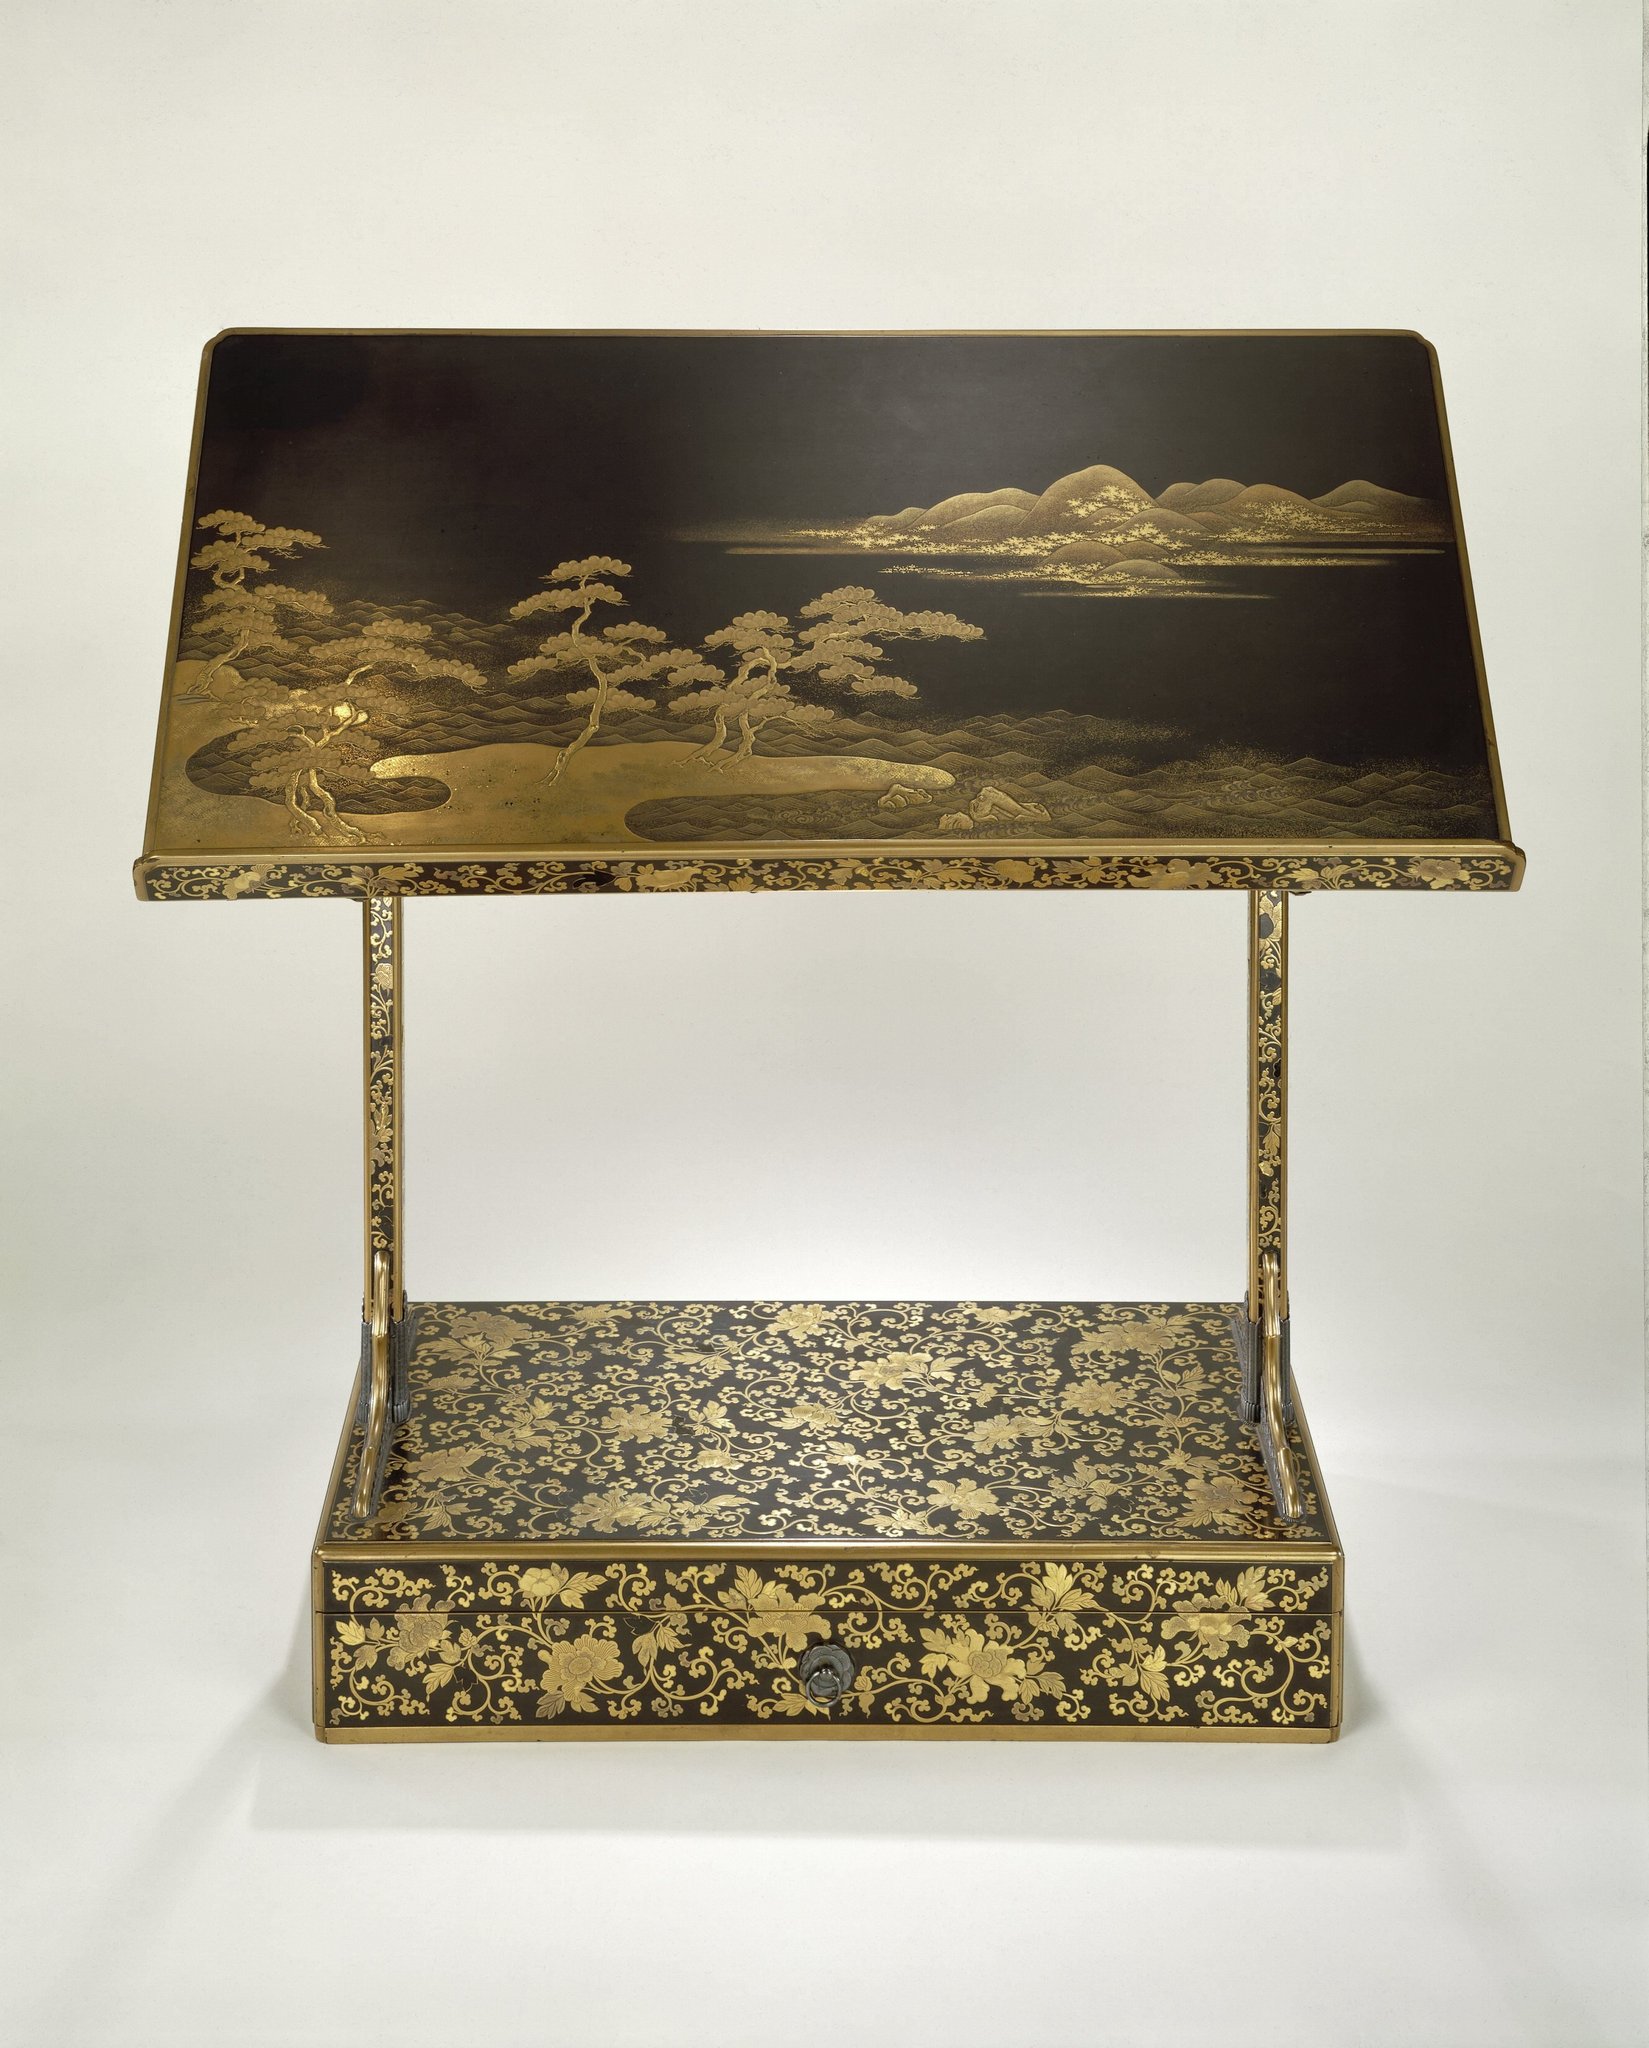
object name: lectern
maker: Anonymous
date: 1700-1800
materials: gold, lacquer, wood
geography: japan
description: The upper surface of this luxuriously decorated lectern is adorned with the pine trees found on the coast near the region of Sumiyoshi. Sumiyoshi Myojin, one of the Shinto deities of Waka, a form of Japanese poetry, is venerated in the Sumiyoshi shrine. Accordingly, this nature scene is a particularly fitting decoration for a lectern.